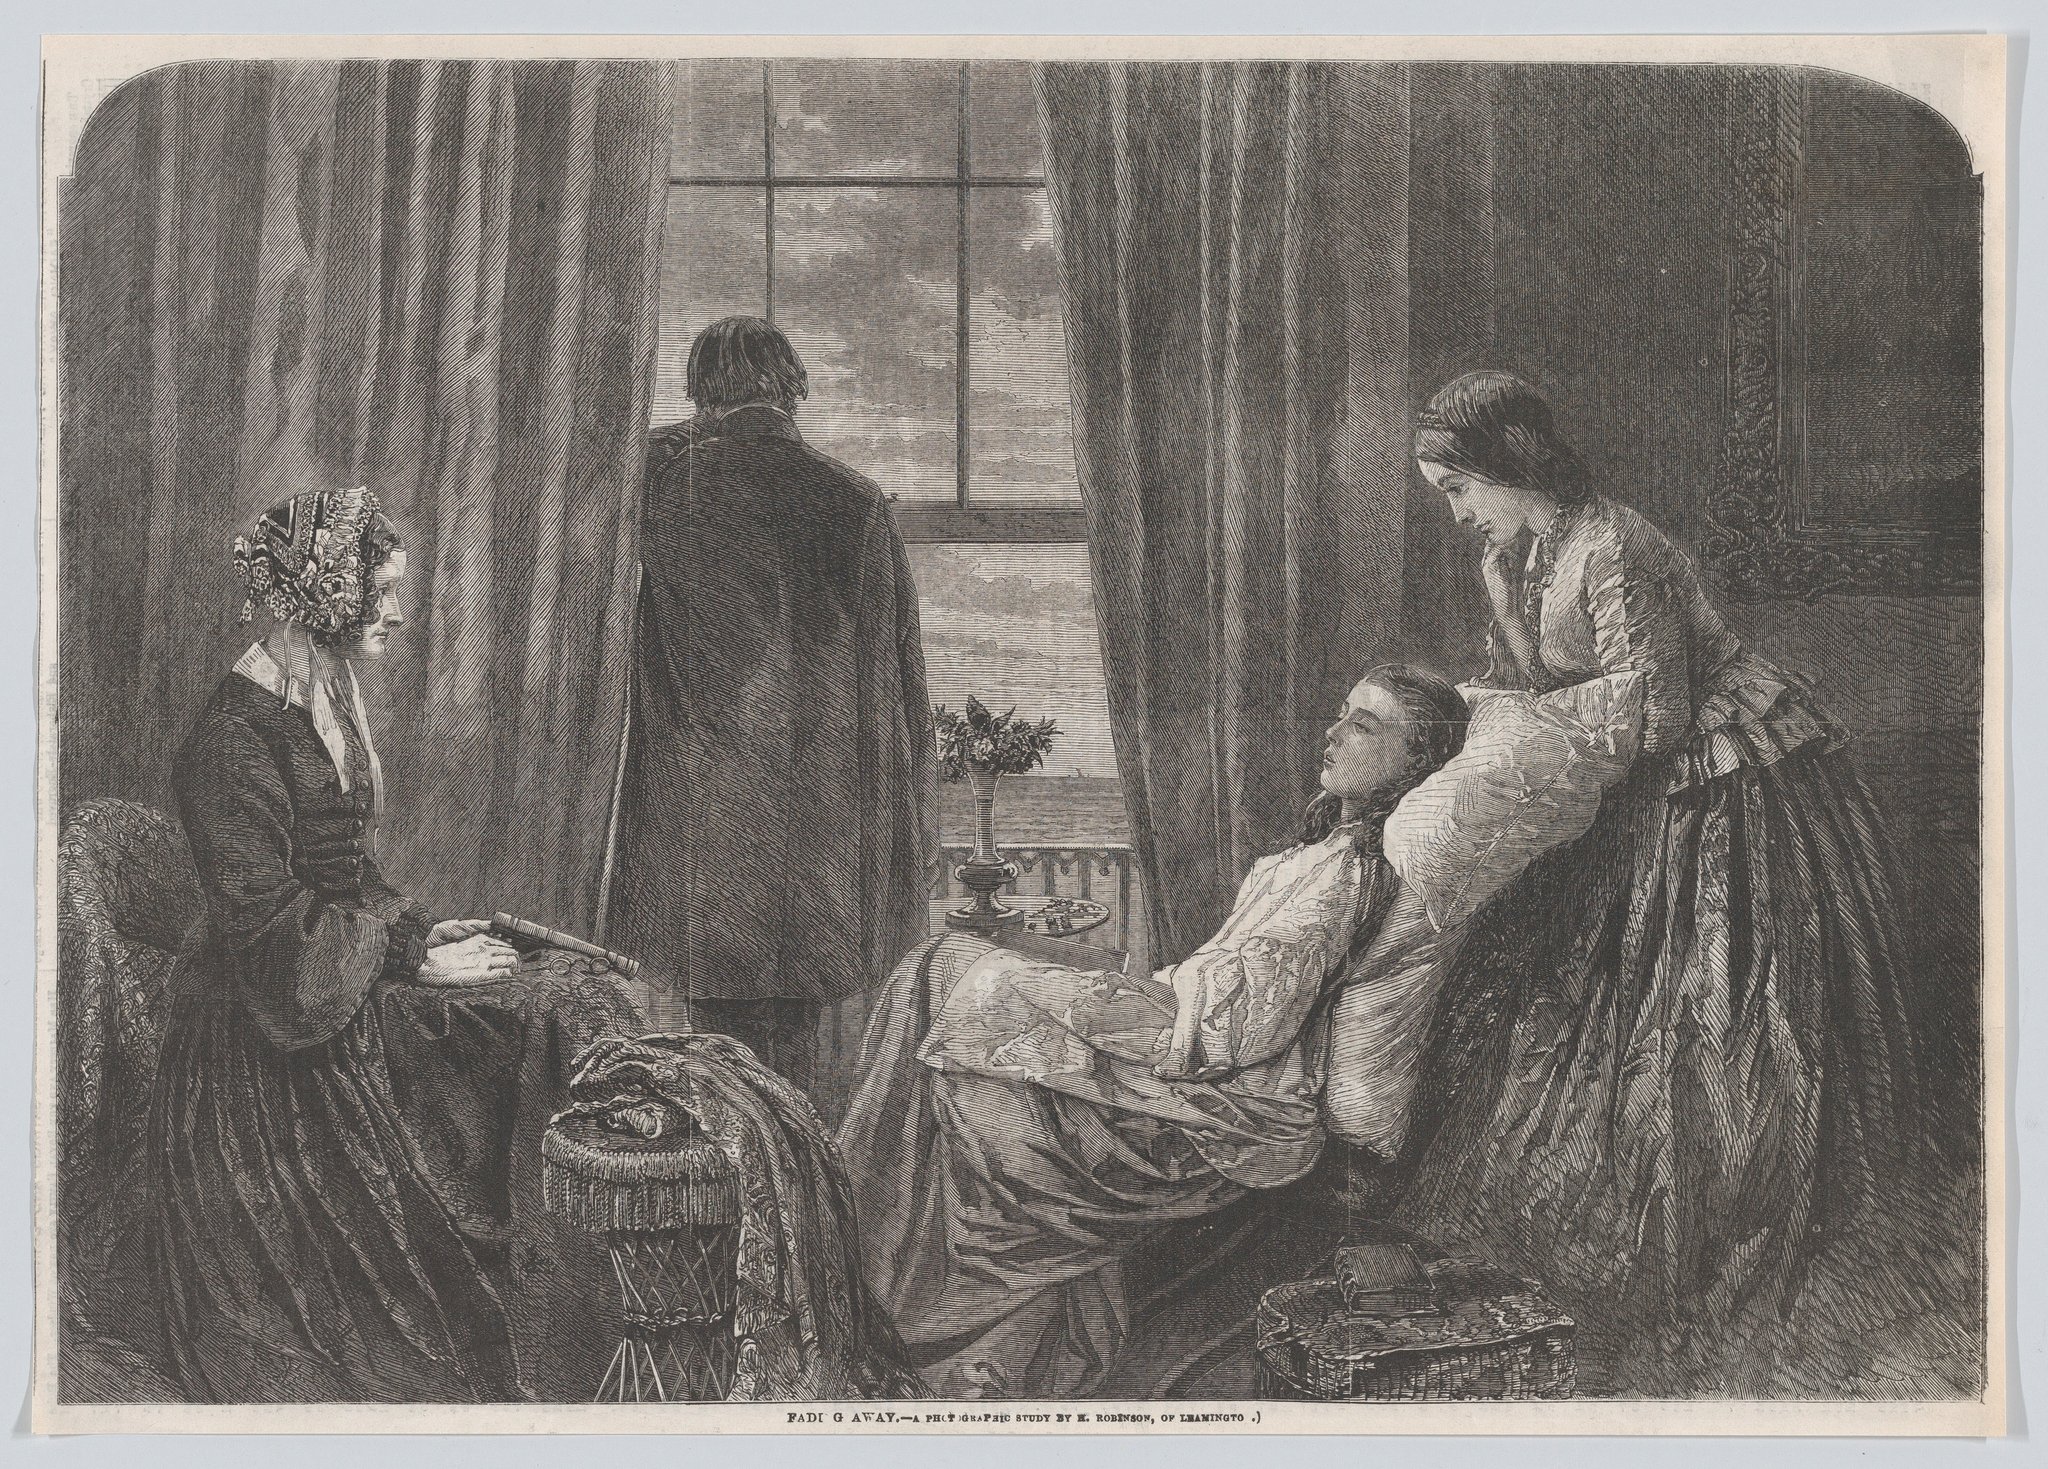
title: Fading Away, from "Illustrated Times"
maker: henry peach robinson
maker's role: artist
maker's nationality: british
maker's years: 1830-1901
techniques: engraving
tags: girls,men,women,death,family